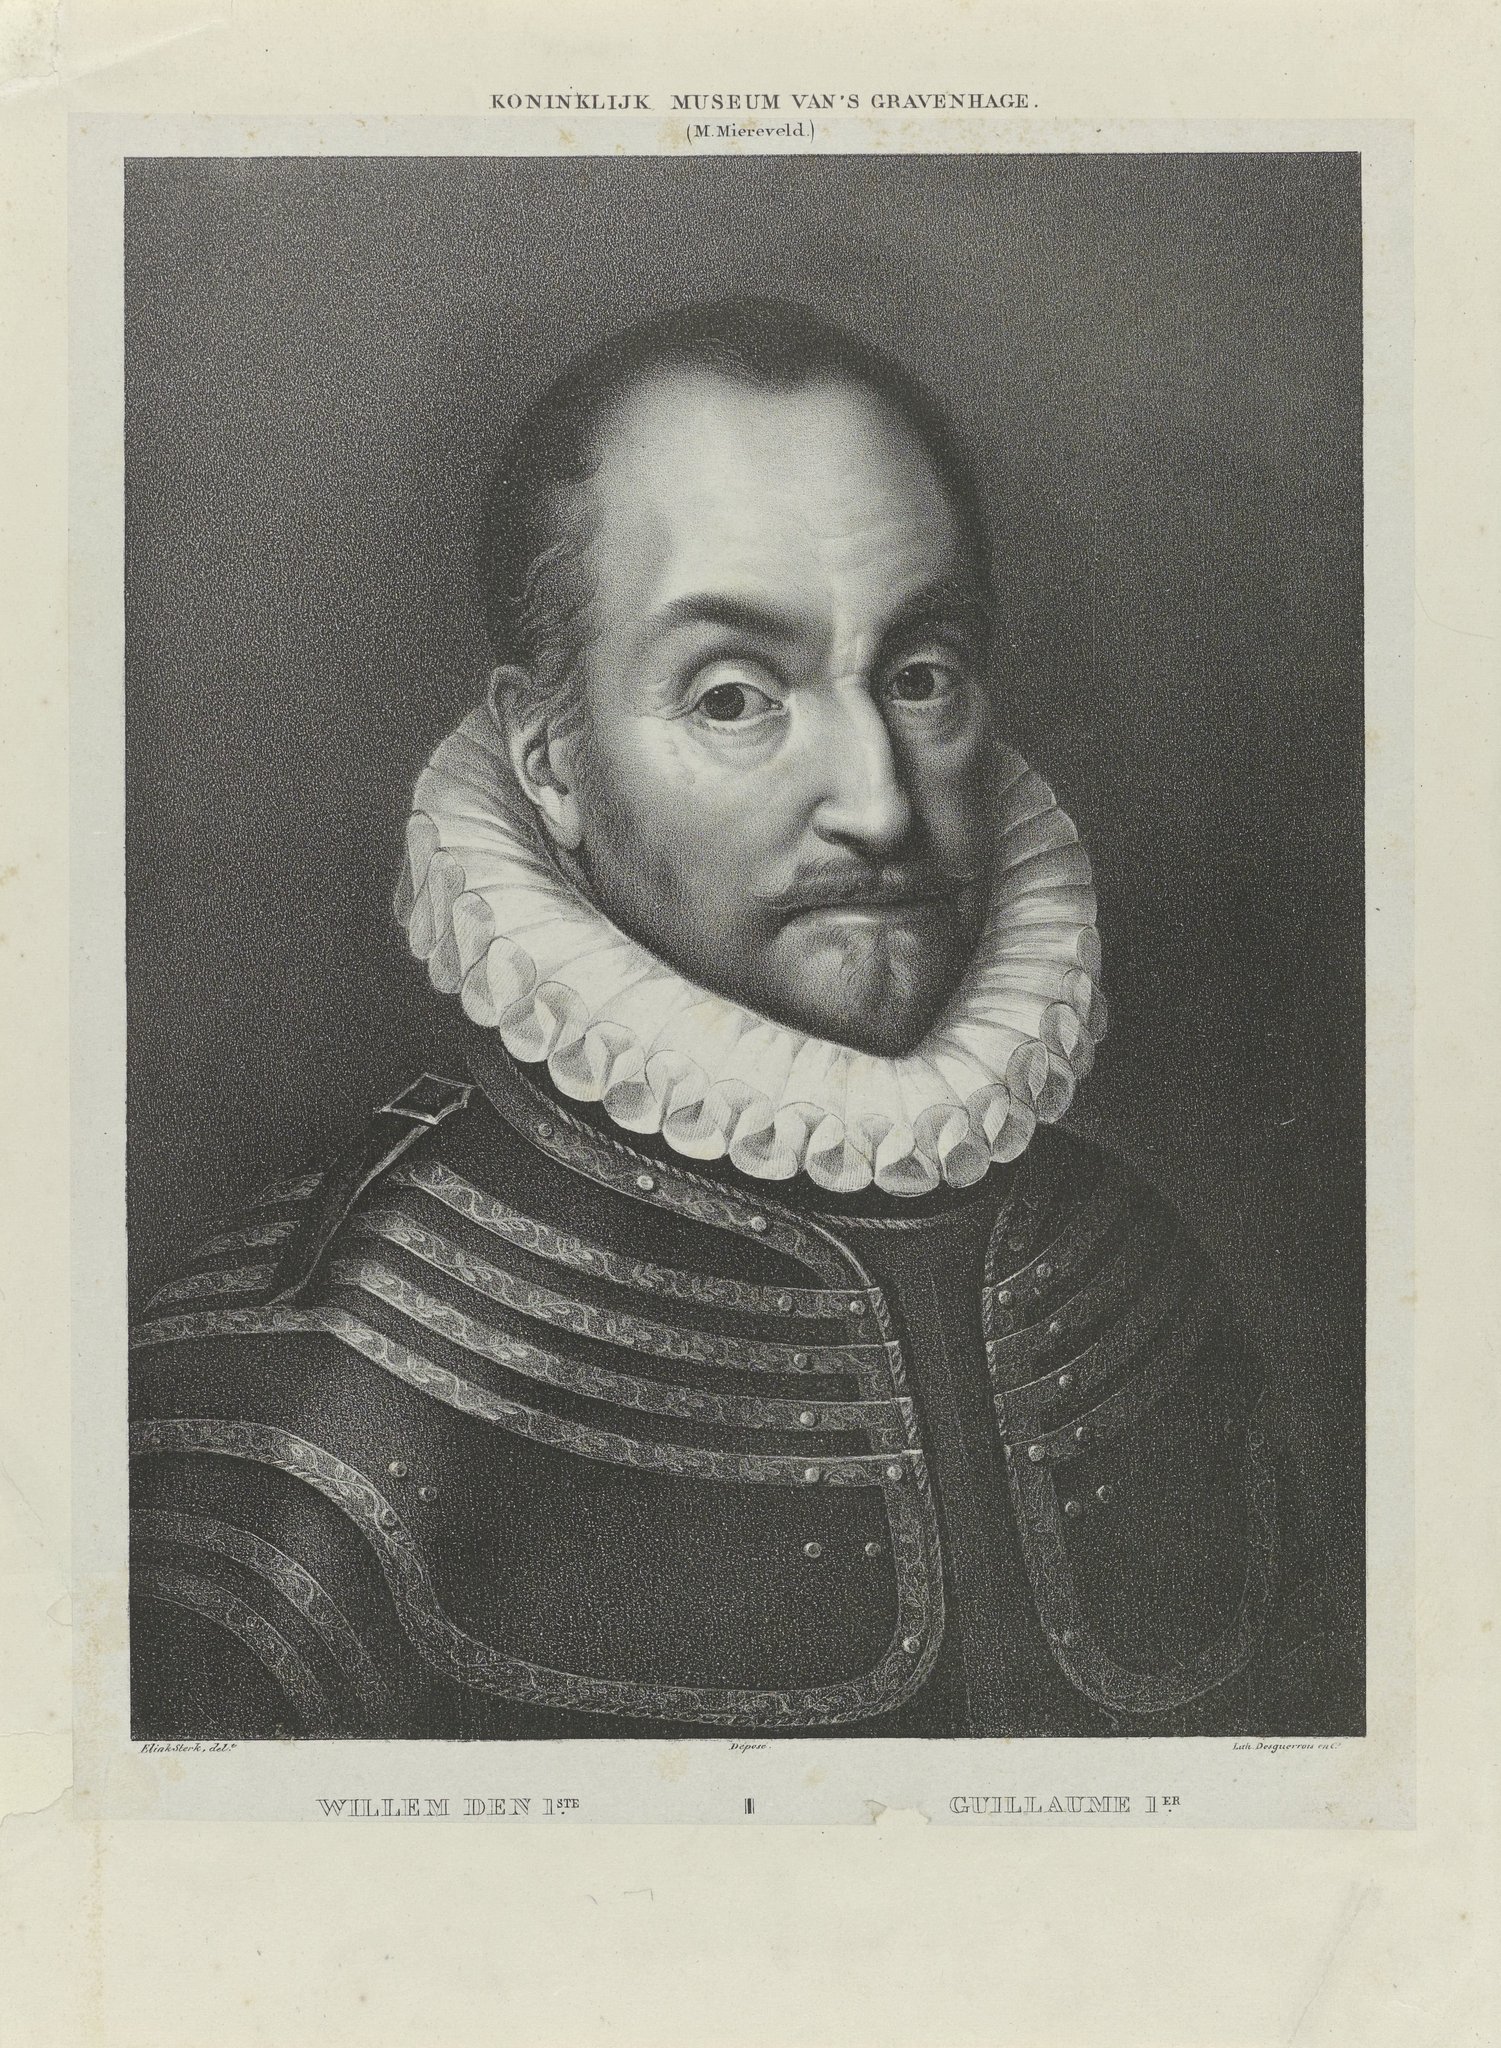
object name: print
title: Portret van Willem I, prins van Oranje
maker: michiel jansz van mierevelt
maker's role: draughtsman, painter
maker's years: 1567-1641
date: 1850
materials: paper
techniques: lithograph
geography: amsterdam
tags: delft, william i (prince of orange)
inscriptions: collector's mark: Lugt 2233, collector's mark: Lugt 963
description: De hier vermelde titel verwijst naar de hoogst verkregen titel van de geportretteerde, niet per se naar de titel die de geportretteerde op deze voorstelling draagt.